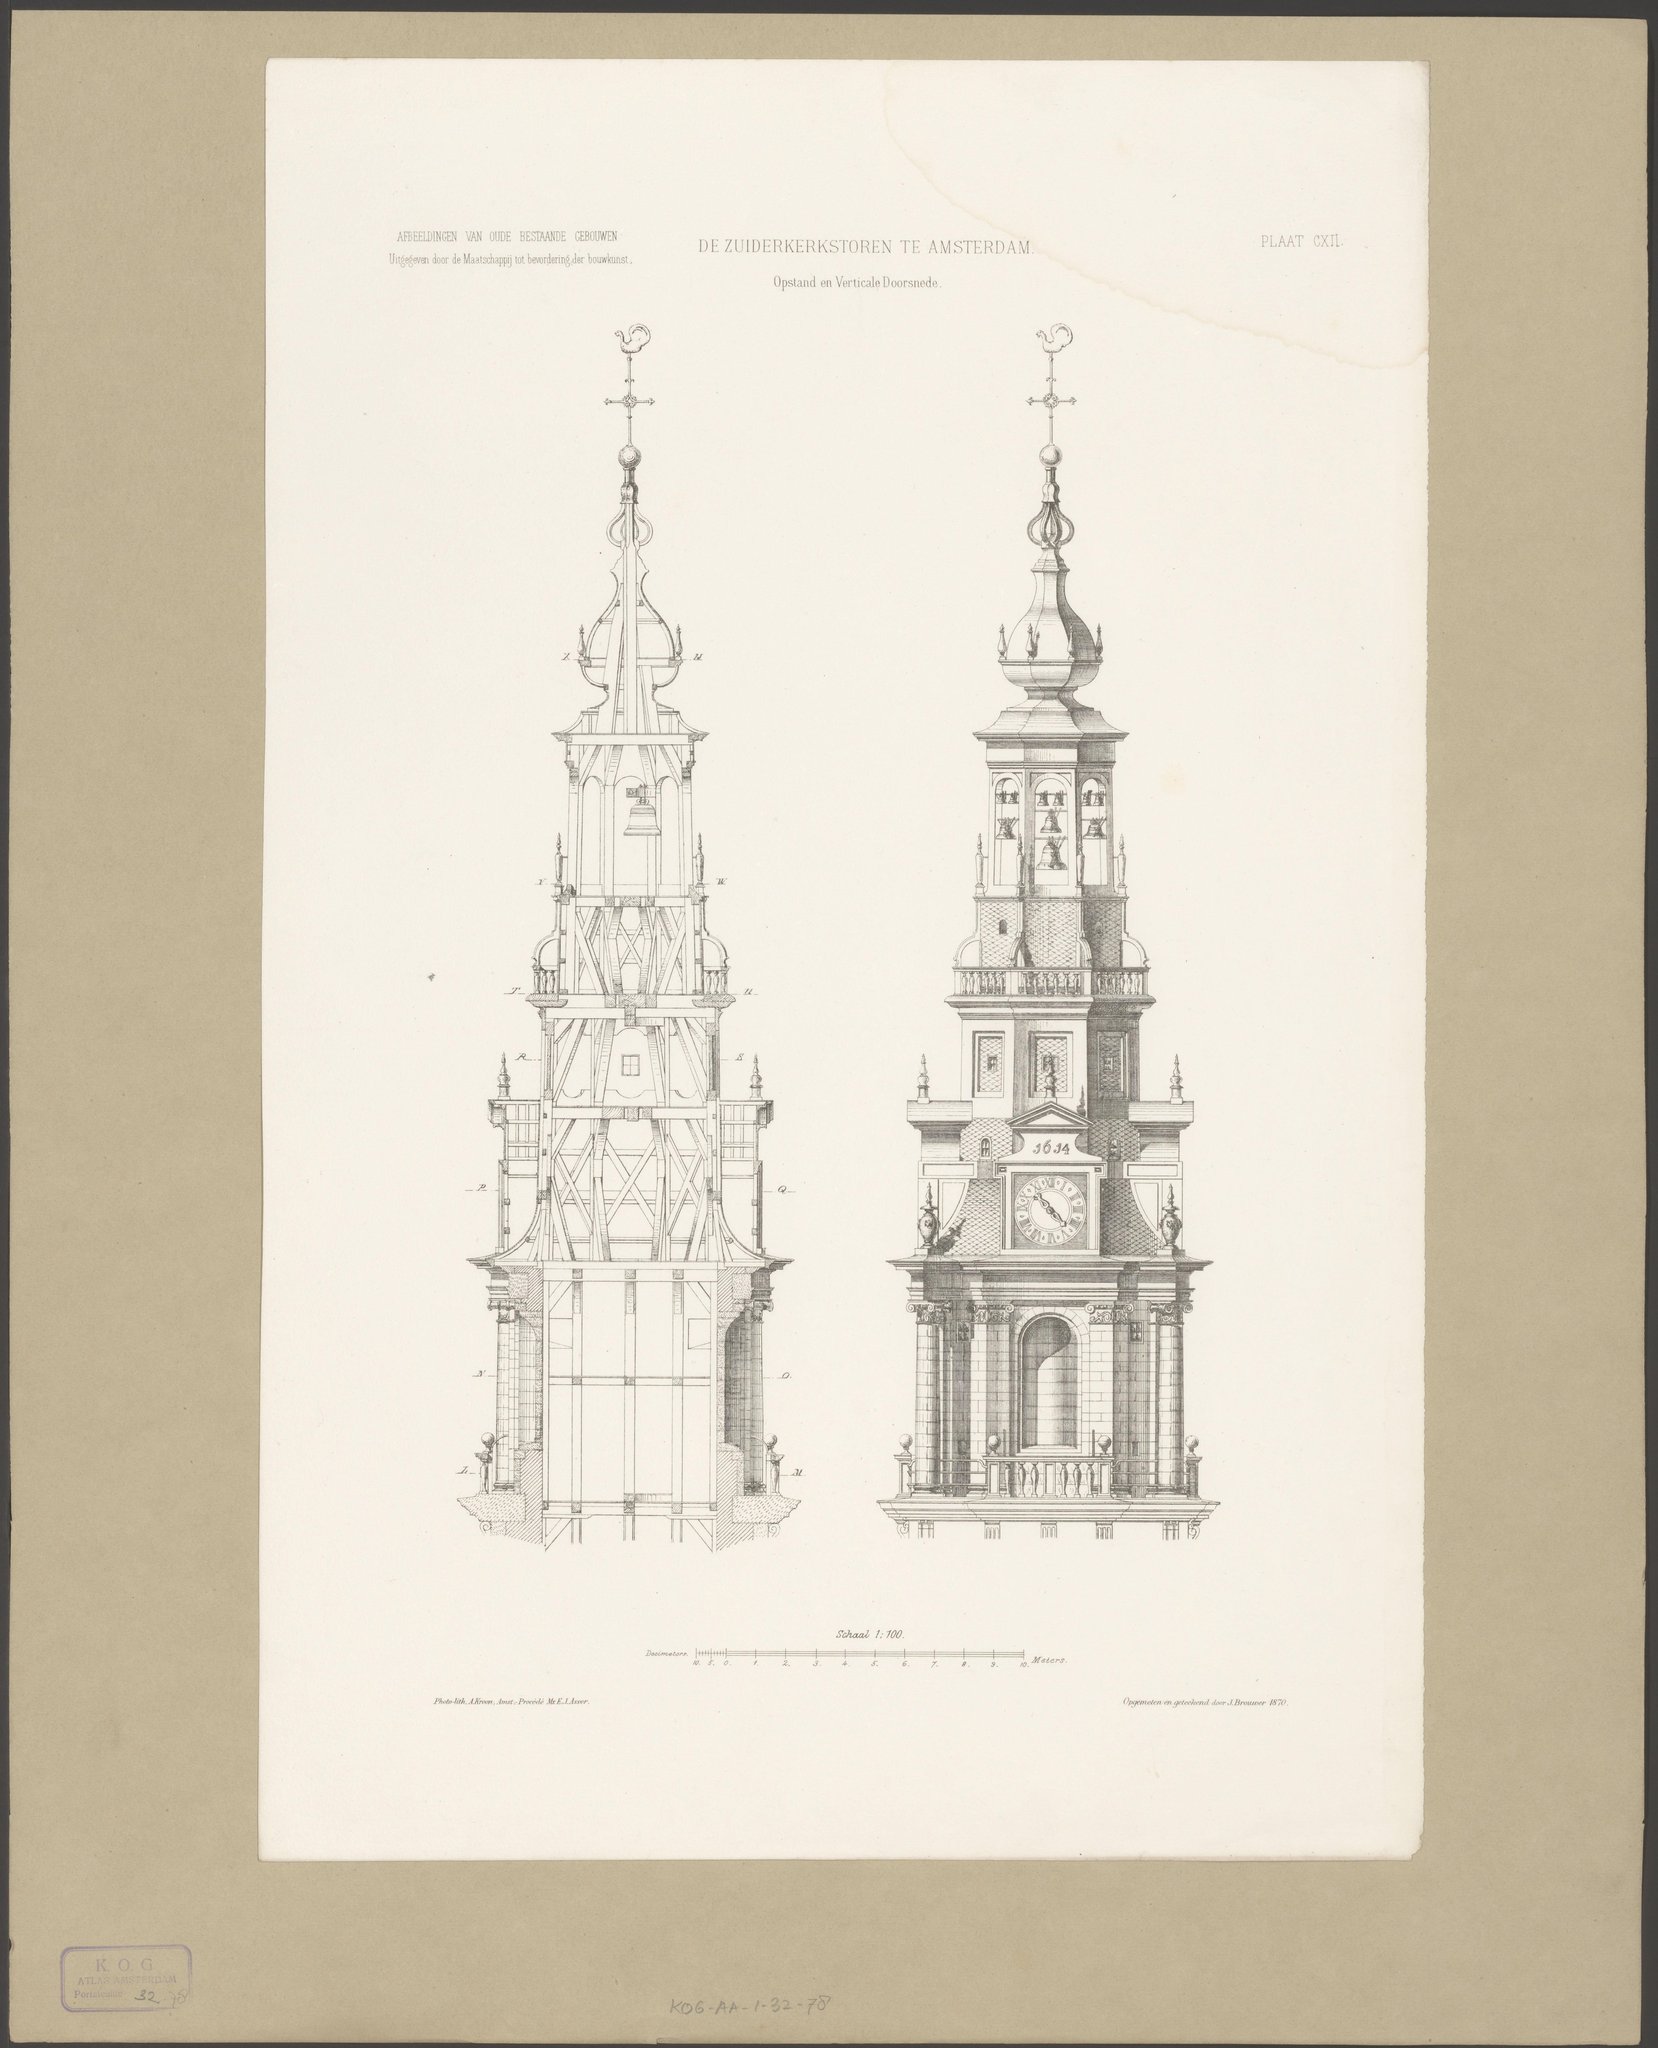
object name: photomechanical print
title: De Zuiderkerkstoren te Amsterdam. Opstand en Verticale Doorsnede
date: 1870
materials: paper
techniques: photolithograph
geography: amsterdam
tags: plan ~ architecture, parts of church exterior and annexes: tower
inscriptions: collector's mark: Lugt 1641b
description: Rechtsboven genummerd: Plaat CXII. Onderwerpsrubriek binnen de Atlas Amsterdam: Kerkwezen: Hervormde Gemeente: Zuiderkerk.